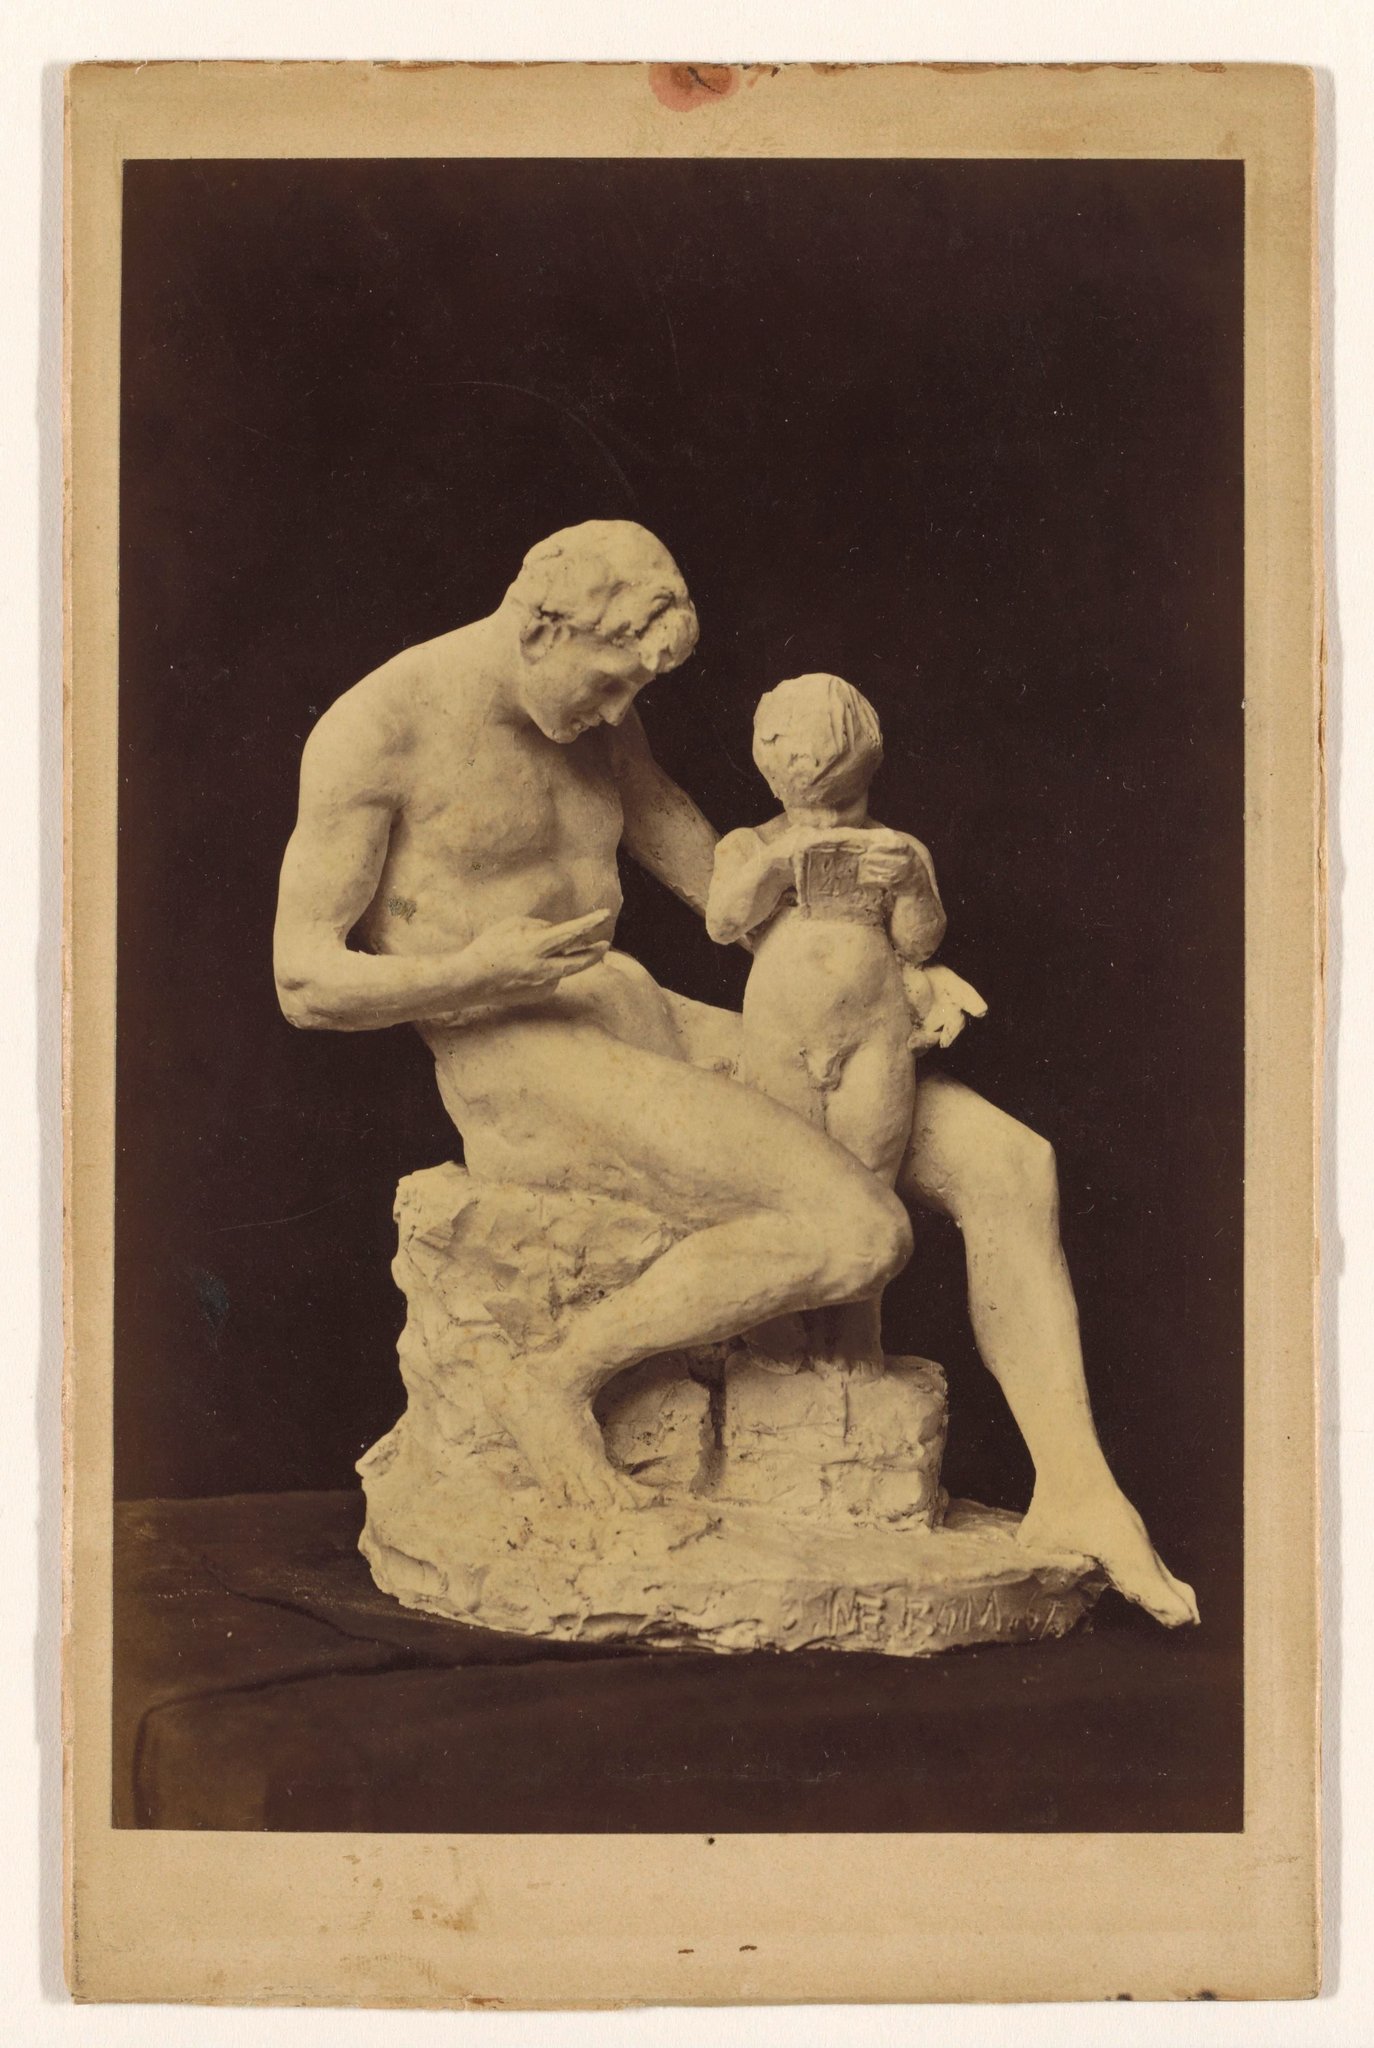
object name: photograph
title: Ontwerp voor sculptuur van man en kind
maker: Anonymous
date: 1867-1890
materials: cardboard, paper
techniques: albumen print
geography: rome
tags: piece of sculpture, reproduction of a piece of sculpture, rome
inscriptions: collector's mark: ‘Vosmaer’